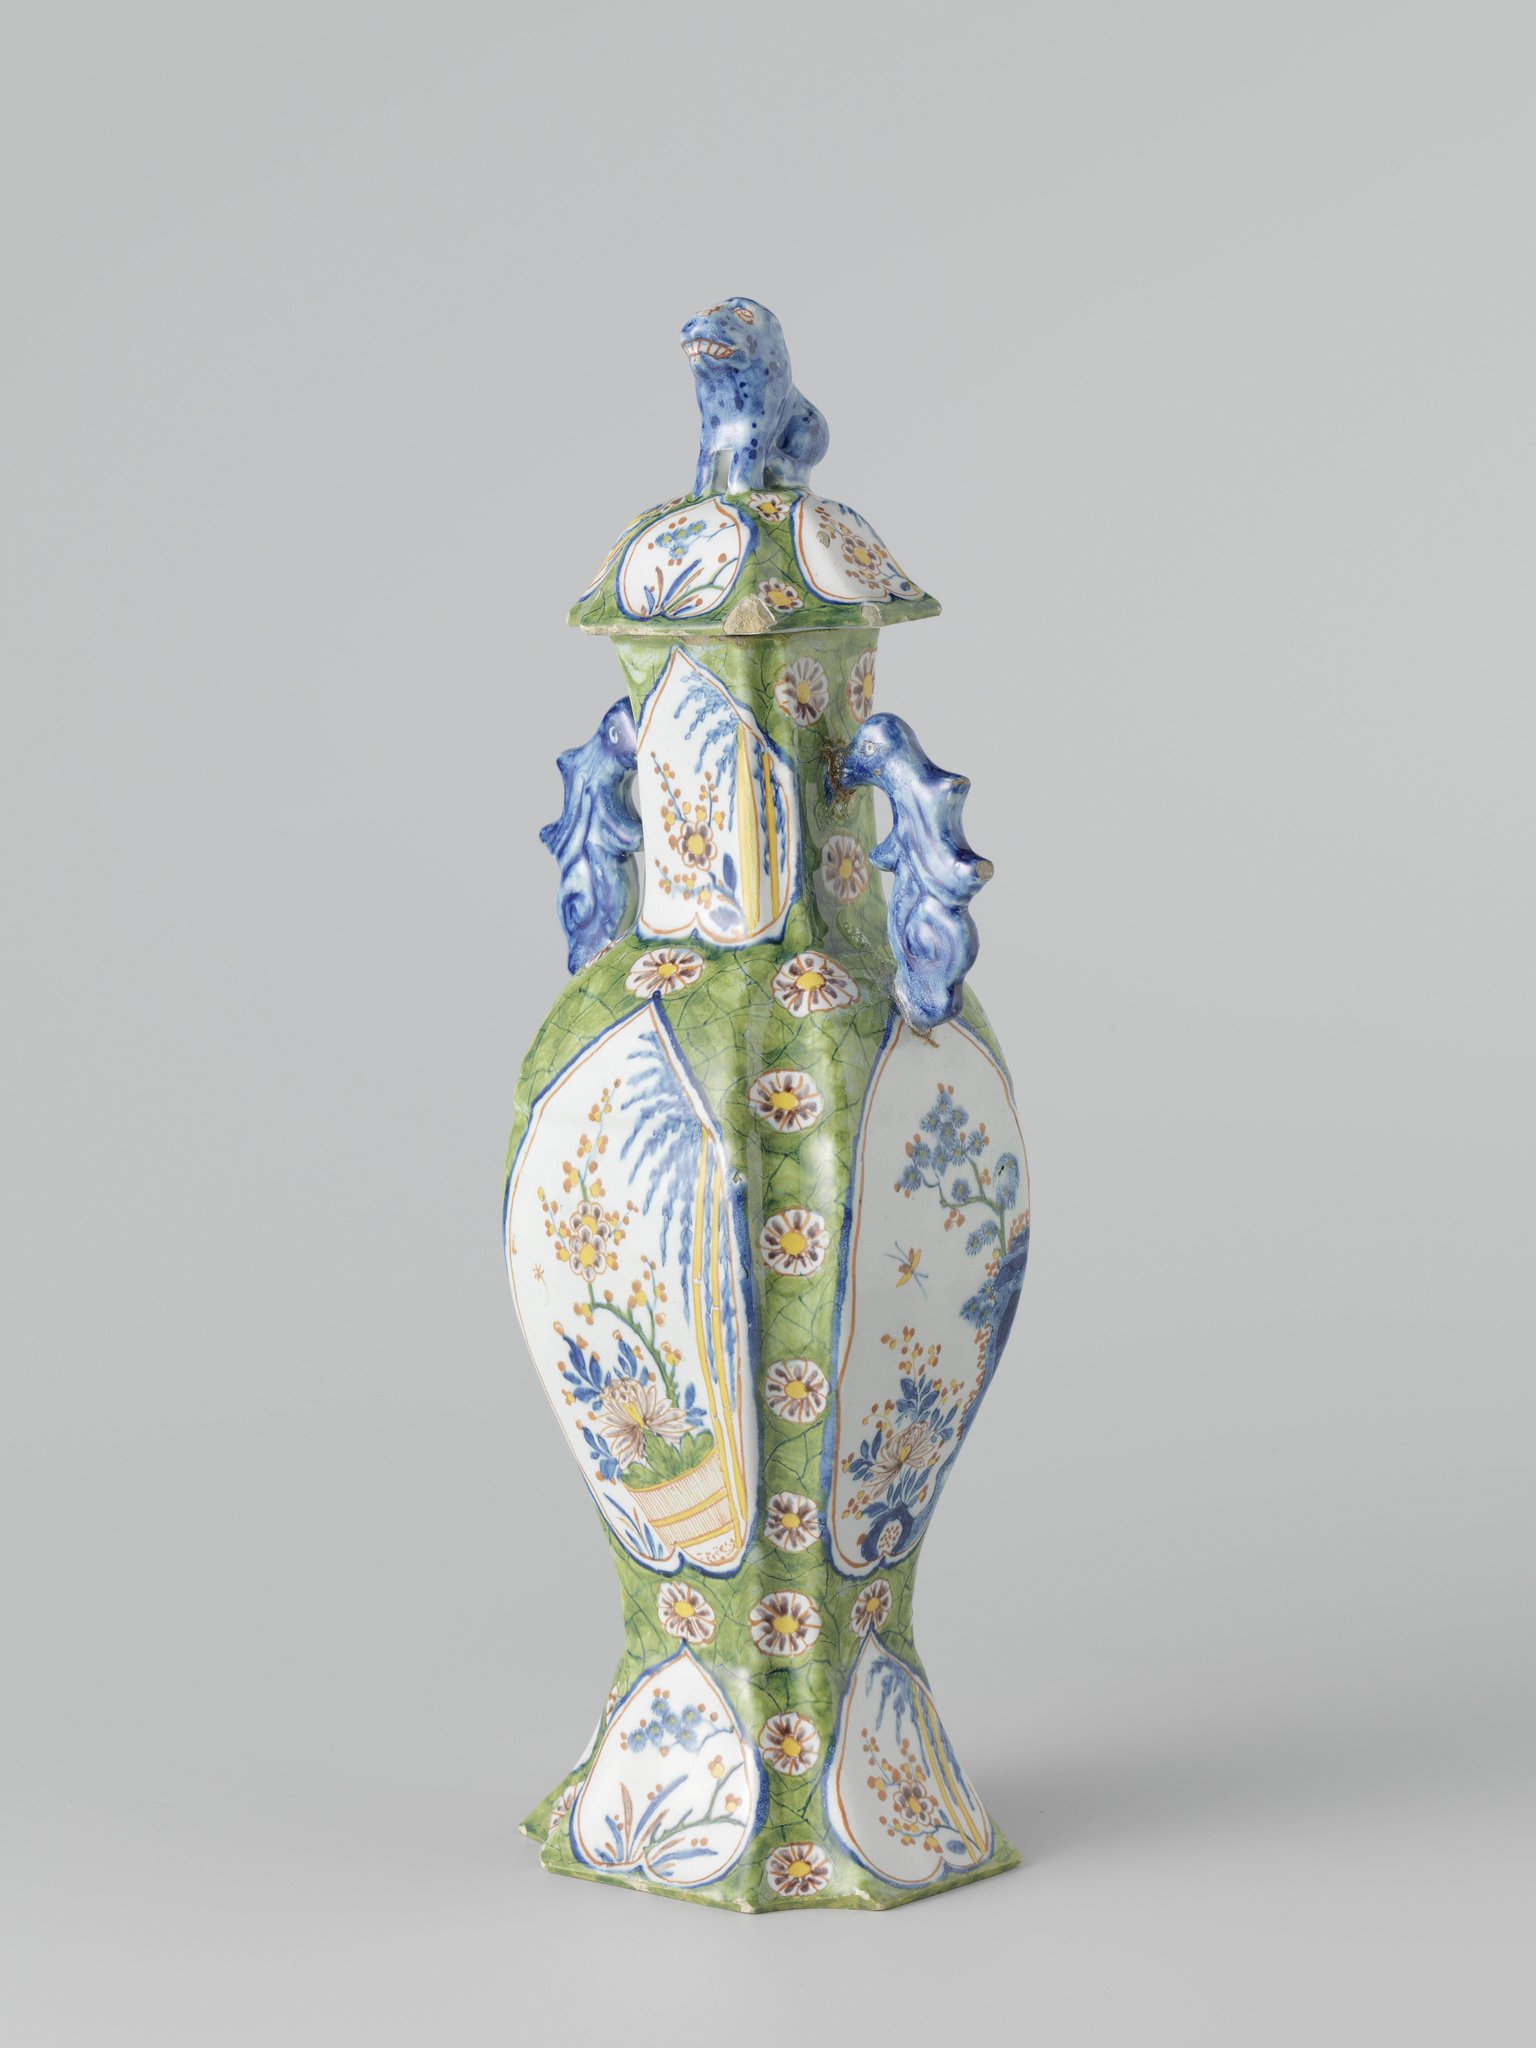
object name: lid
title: Deksel van dekselpot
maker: Anonymous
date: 1740-1780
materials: faience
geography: delft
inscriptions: collector's mark: ‘koninklijk oudheidkundig genootschap nr. 29’, mark: ‘D / 7’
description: Deksel van dekselpot van faience. Veelkleurig beschilderd. De dekselpot is onderdeel van een kaststel.